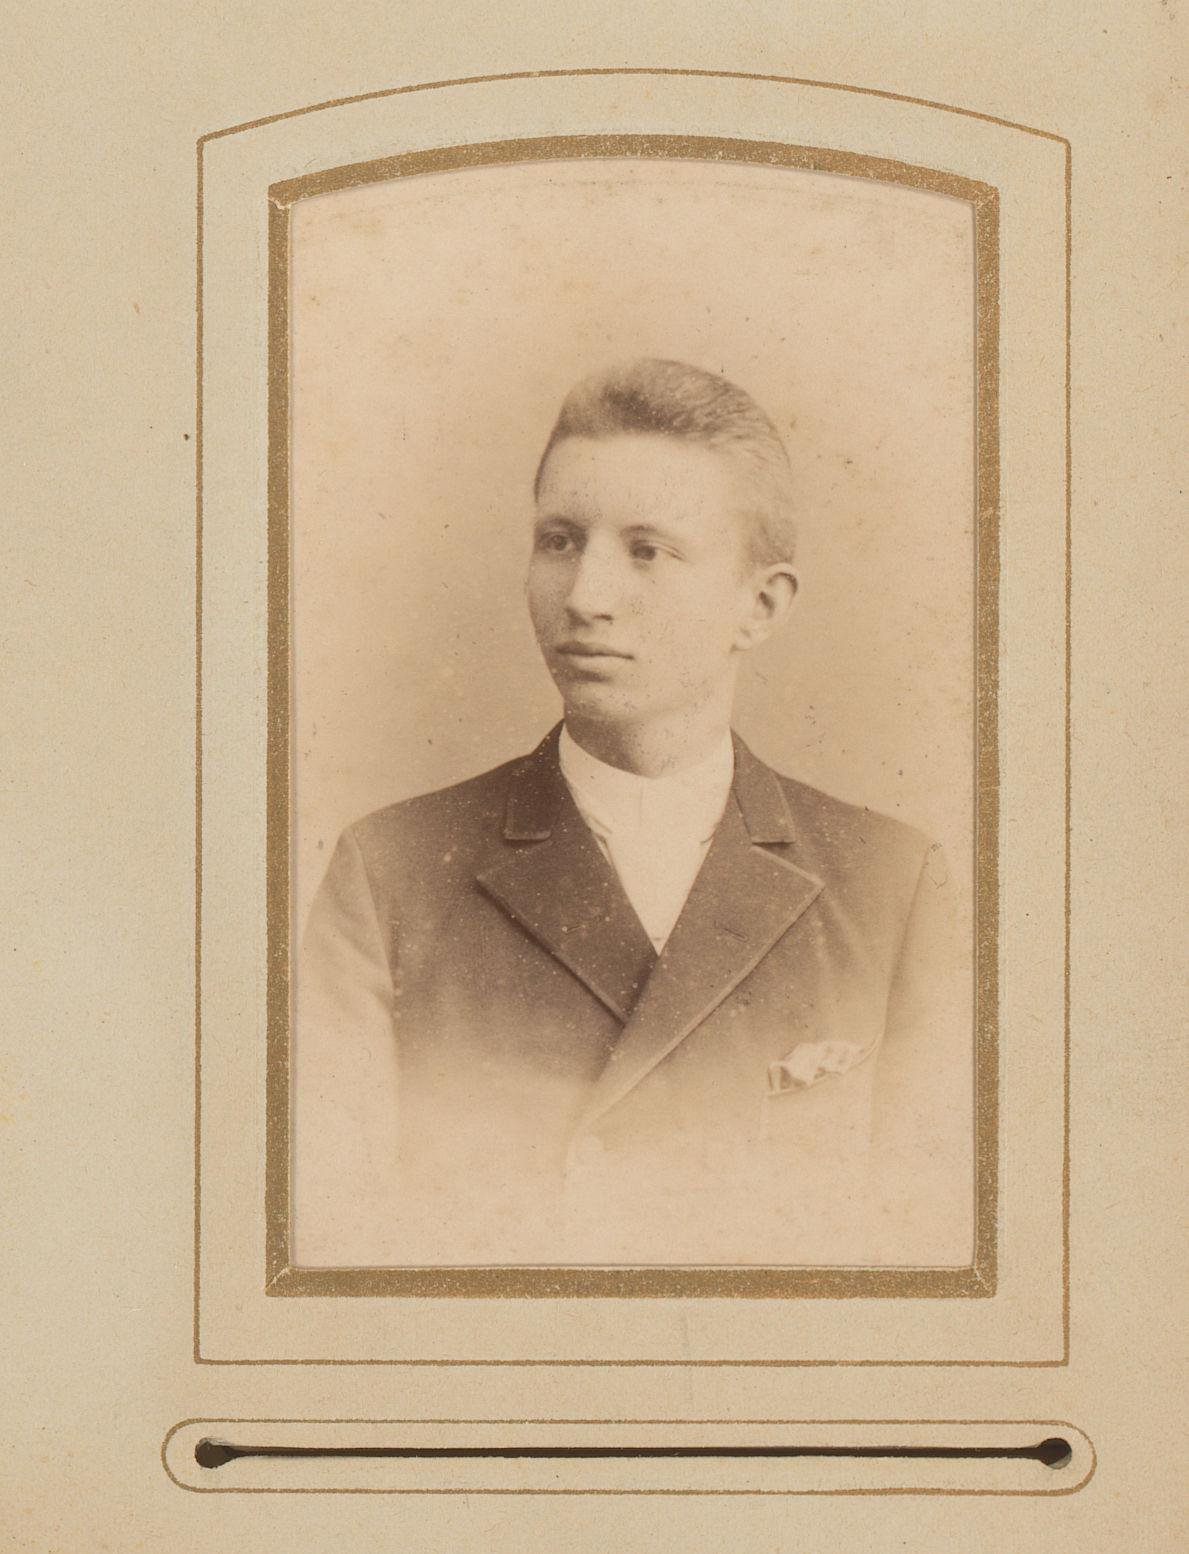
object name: album leaf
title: Portret van een jongeman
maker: august döpke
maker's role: fotograaf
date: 1860-1900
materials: cardboard, photographic support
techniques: albumen print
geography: bremen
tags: historical persons, youth, adolescent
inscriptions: inscription: ‘August Döpke/ Bremen/ Birkenstr. 11, parterre’